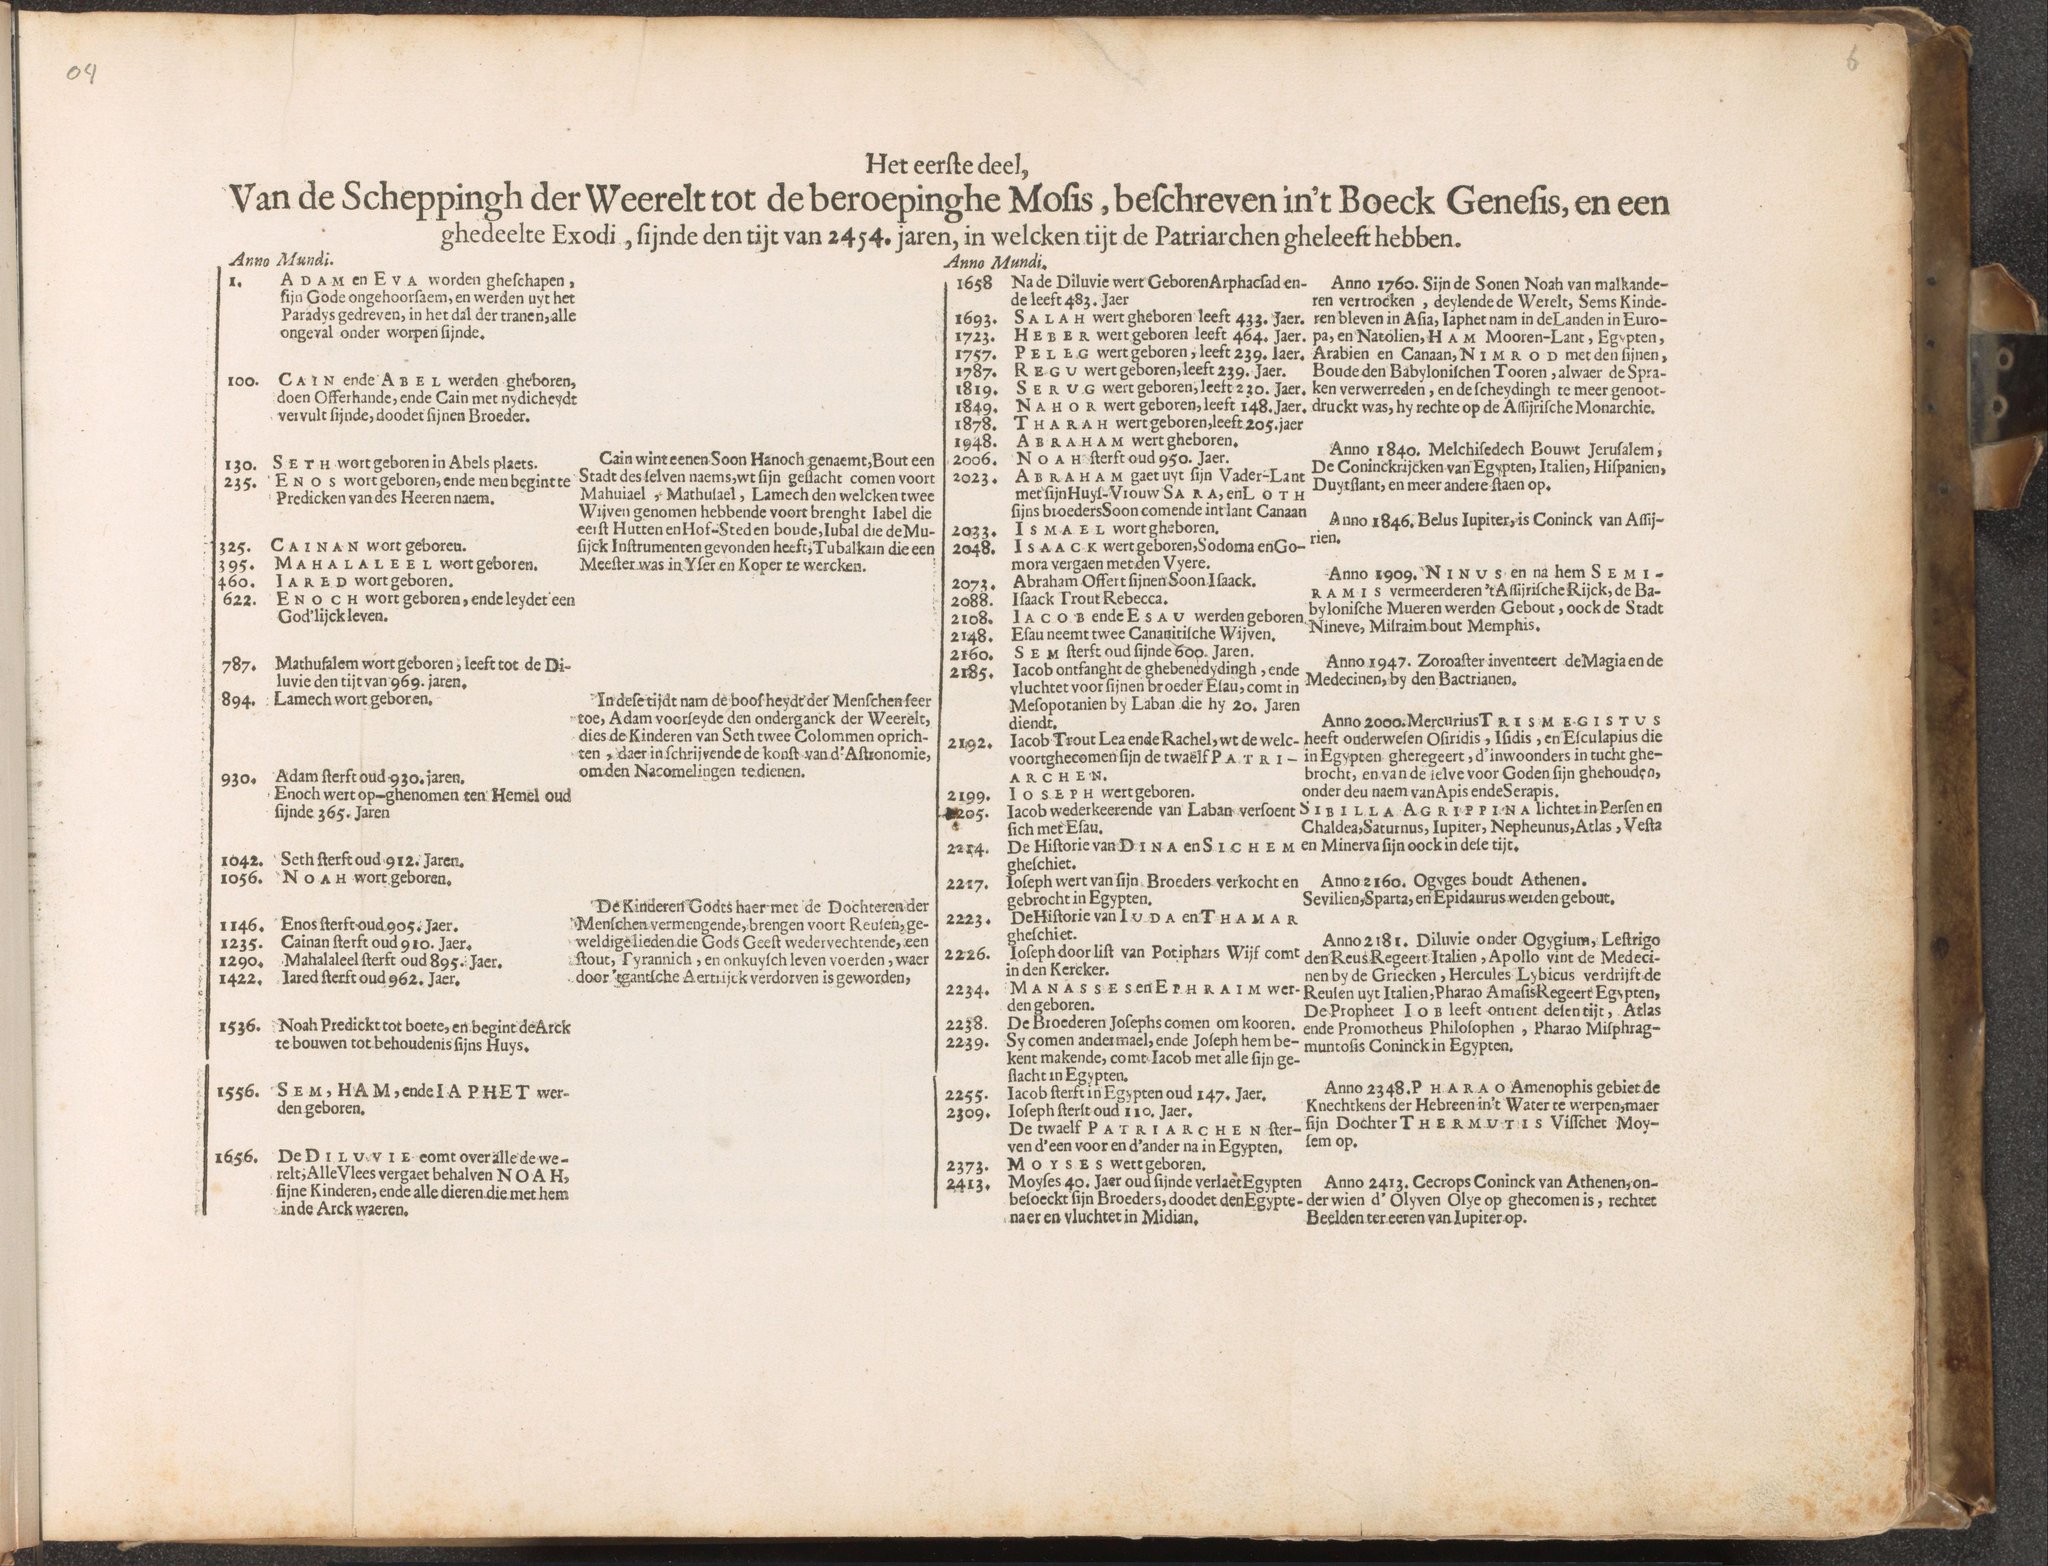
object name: album leaf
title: Den Grooten Emblemata Sacra, bestaande in meer dan vier hondert bybelsche figuren, zoo des Ouden als des Nieuwen Testaments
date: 1653-1654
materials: paper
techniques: letterpress printing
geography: amsterdam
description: Chronologisch overzicht bij het eerste deel in de Grooten Emblemata Sacra, met het opschrift: Van de Scheppingh der Weerelt tot de beroepinghe Mosis, beschreven in't Boeck Genesis, en een ghedeelte Exodi ... Het blad maakt deel uit van een album.